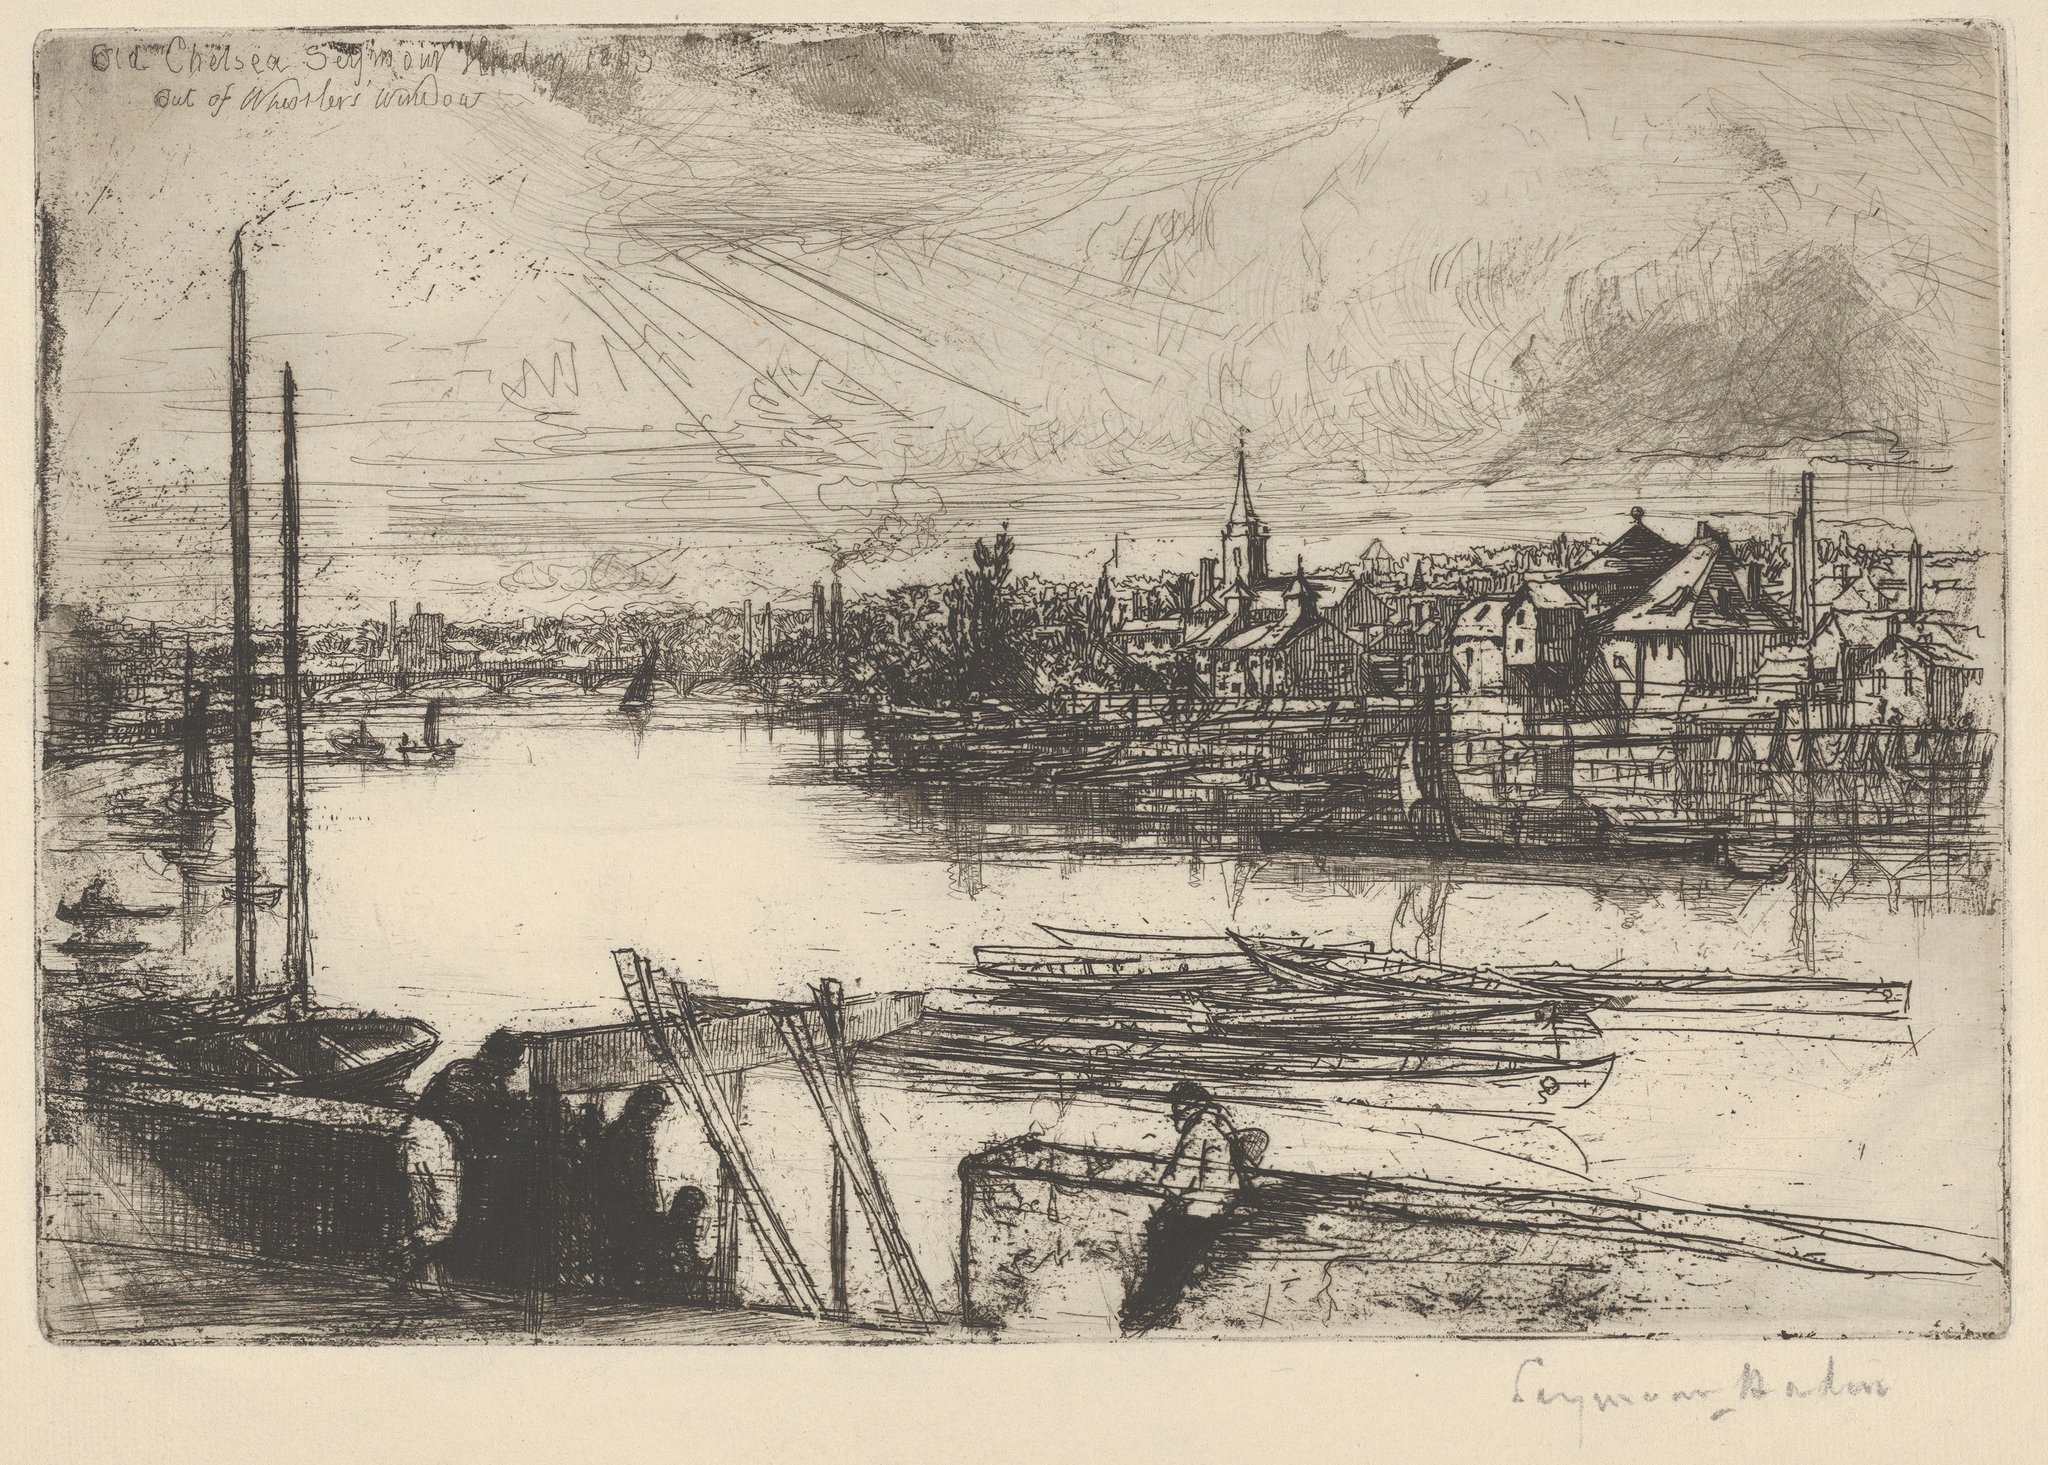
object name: print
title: Battersea Reach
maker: francis seymour haden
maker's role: artist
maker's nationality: british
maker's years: 1818-1910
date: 1863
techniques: drypoint, etching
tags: rivers,boats